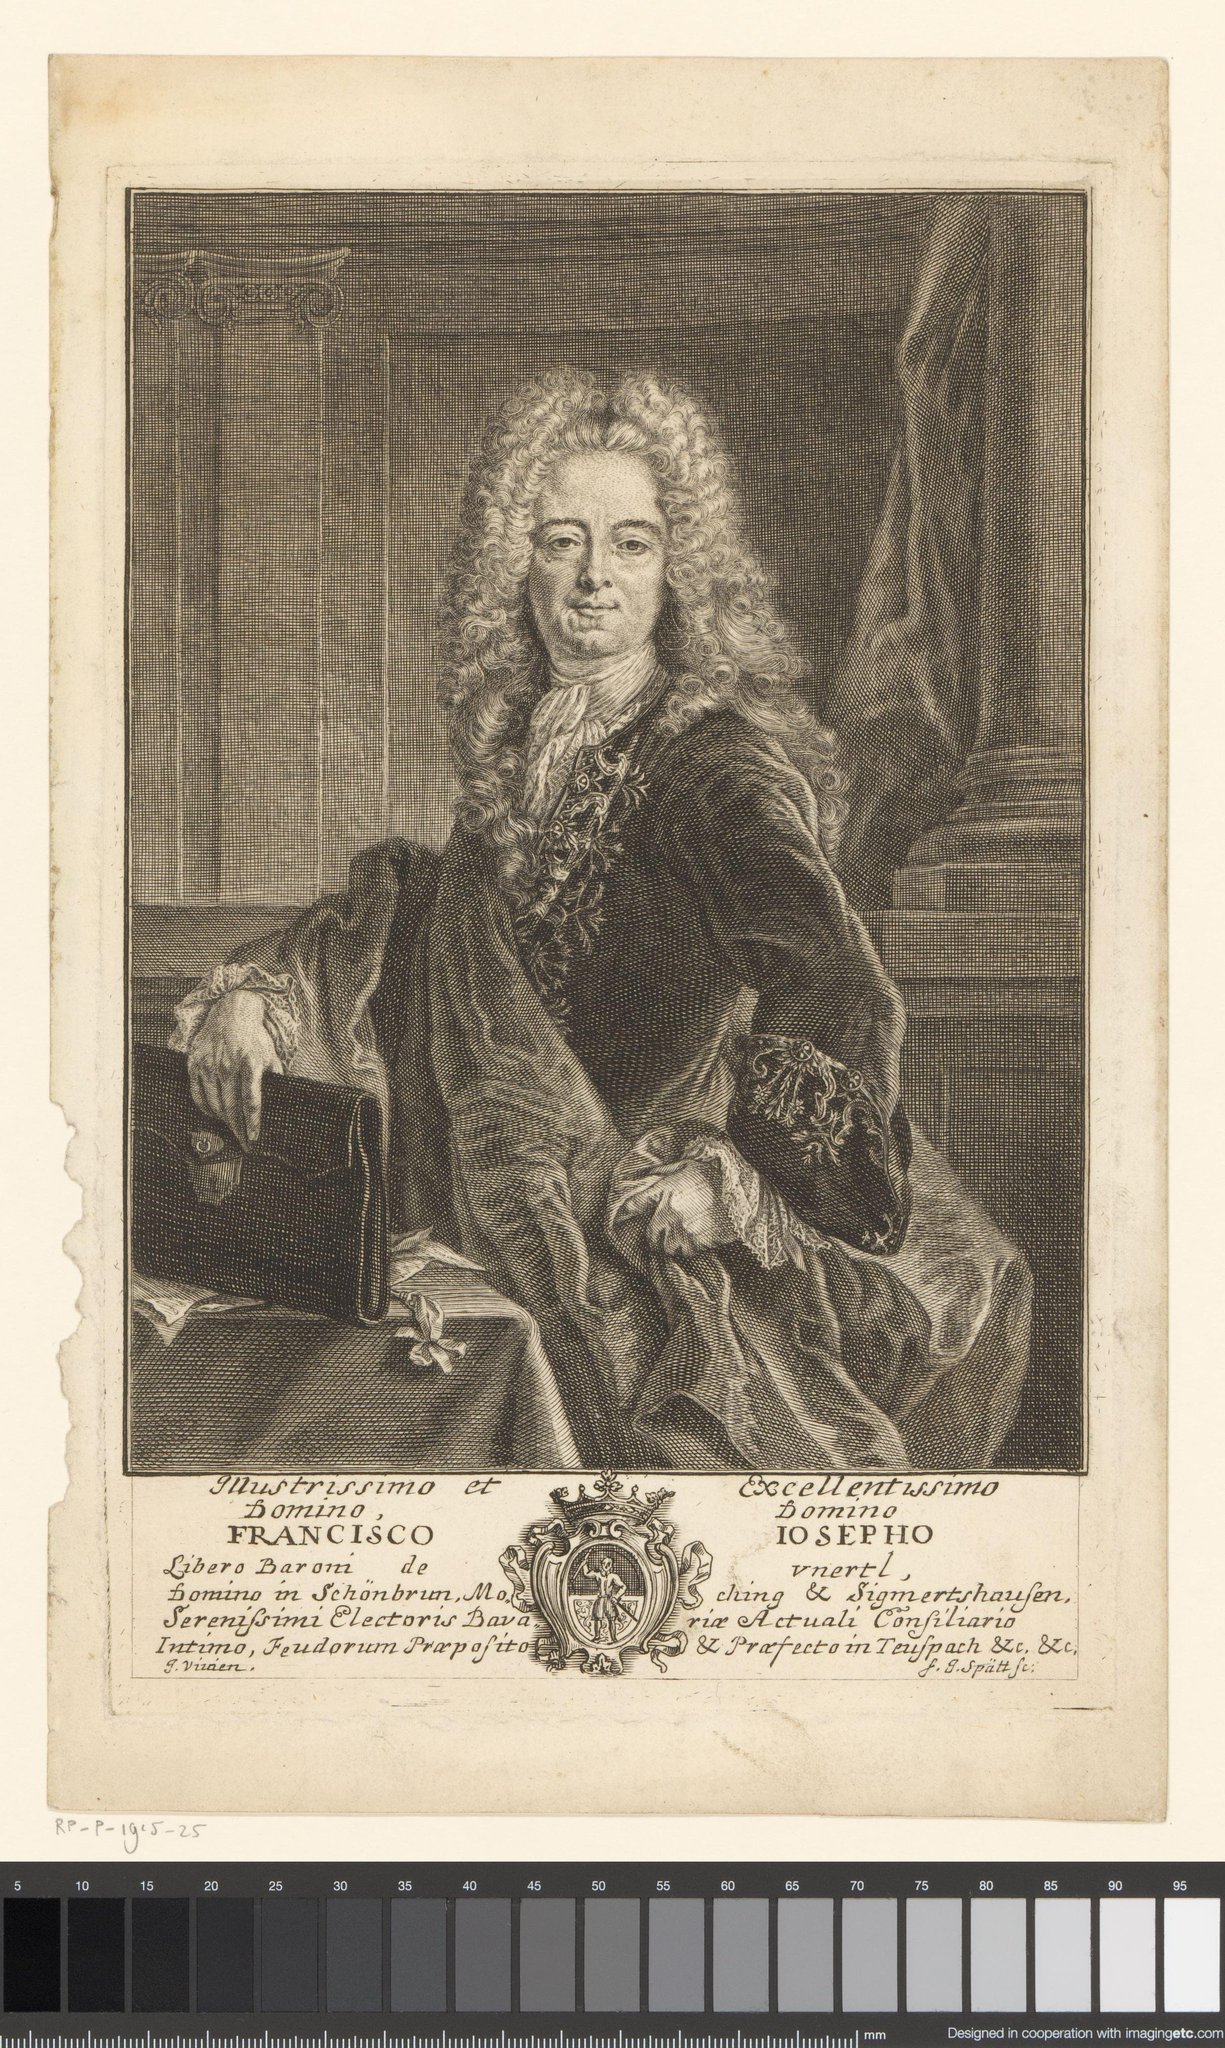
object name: print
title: Portret van Franz Joseph Unertl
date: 1696-1735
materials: paper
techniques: engraving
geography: germany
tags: historical persons, armorial bearing, heraldry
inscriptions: collector's mark: Lugt 2228